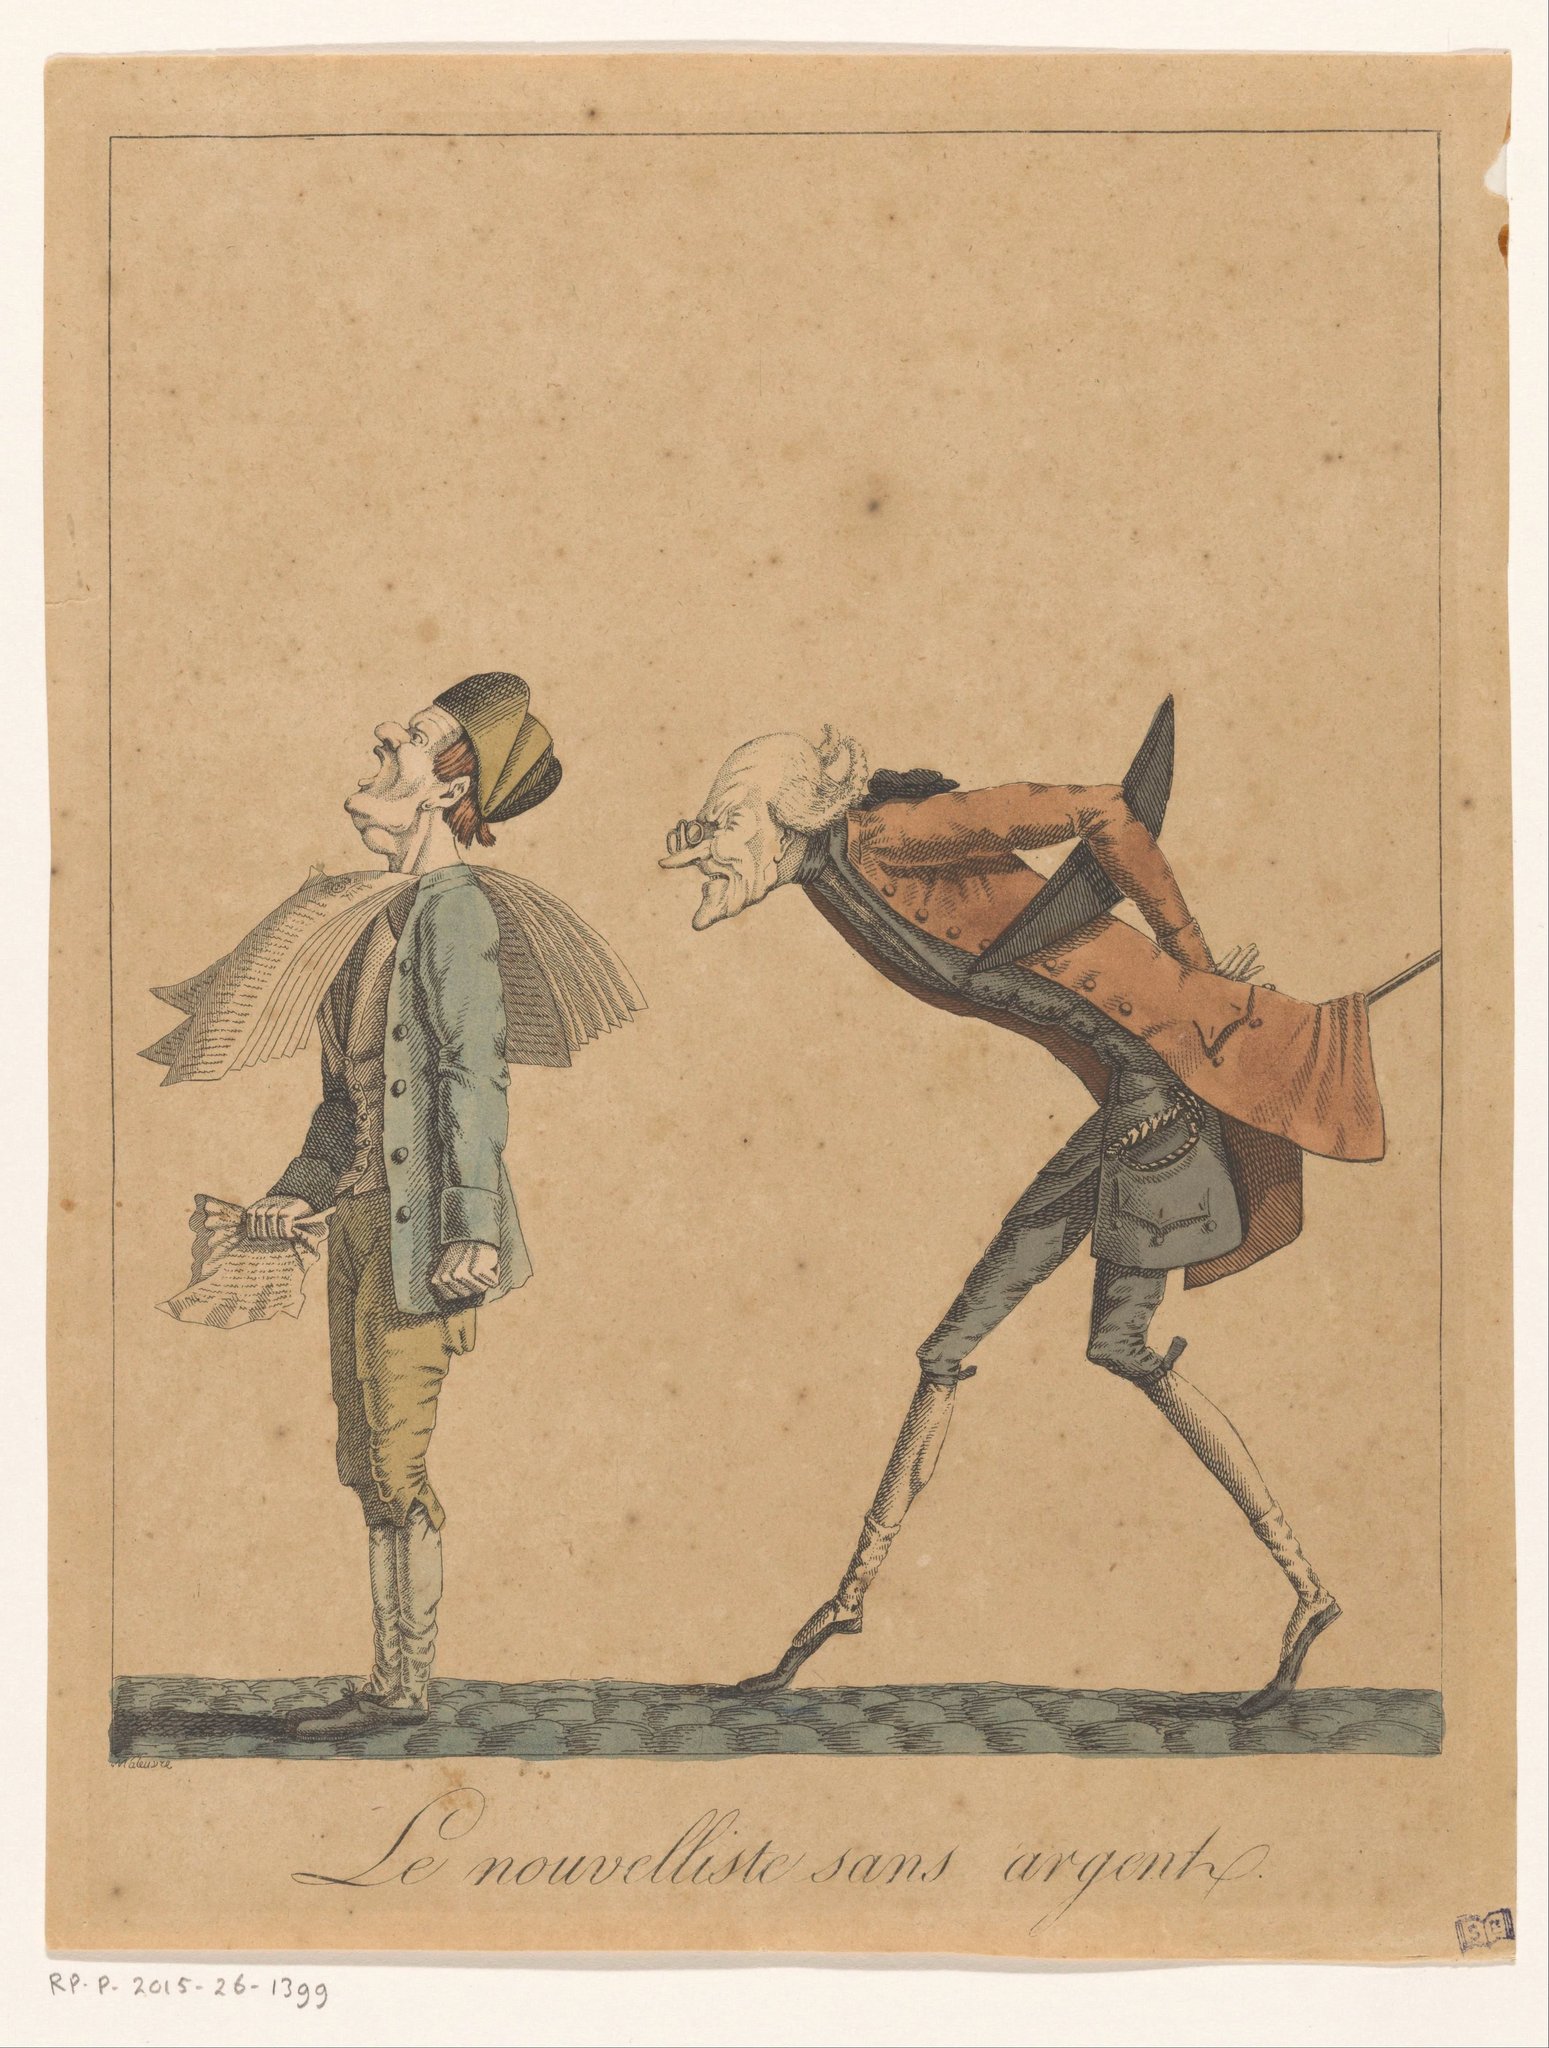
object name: print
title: Man probeert de krant te lezen van de rug van een krantenjongen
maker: pierre maloeuvre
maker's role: print maker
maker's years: 1740-1803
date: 1814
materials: paper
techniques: etching, hand coloring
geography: paris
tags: reading, newsboy, newsman, caricatures (human types), newspaper, news-sheet, political caricatures and satires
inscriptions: collector's mark: Lugt 4779, collector's mark: ‘L.A. de Vries’ 4780, collector's mark: Lugt 2228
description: Een man, mogelijk een schrijver, besluipt een dagbladverkoper. Hij leest de bladen die hij op zijn rug draagt.